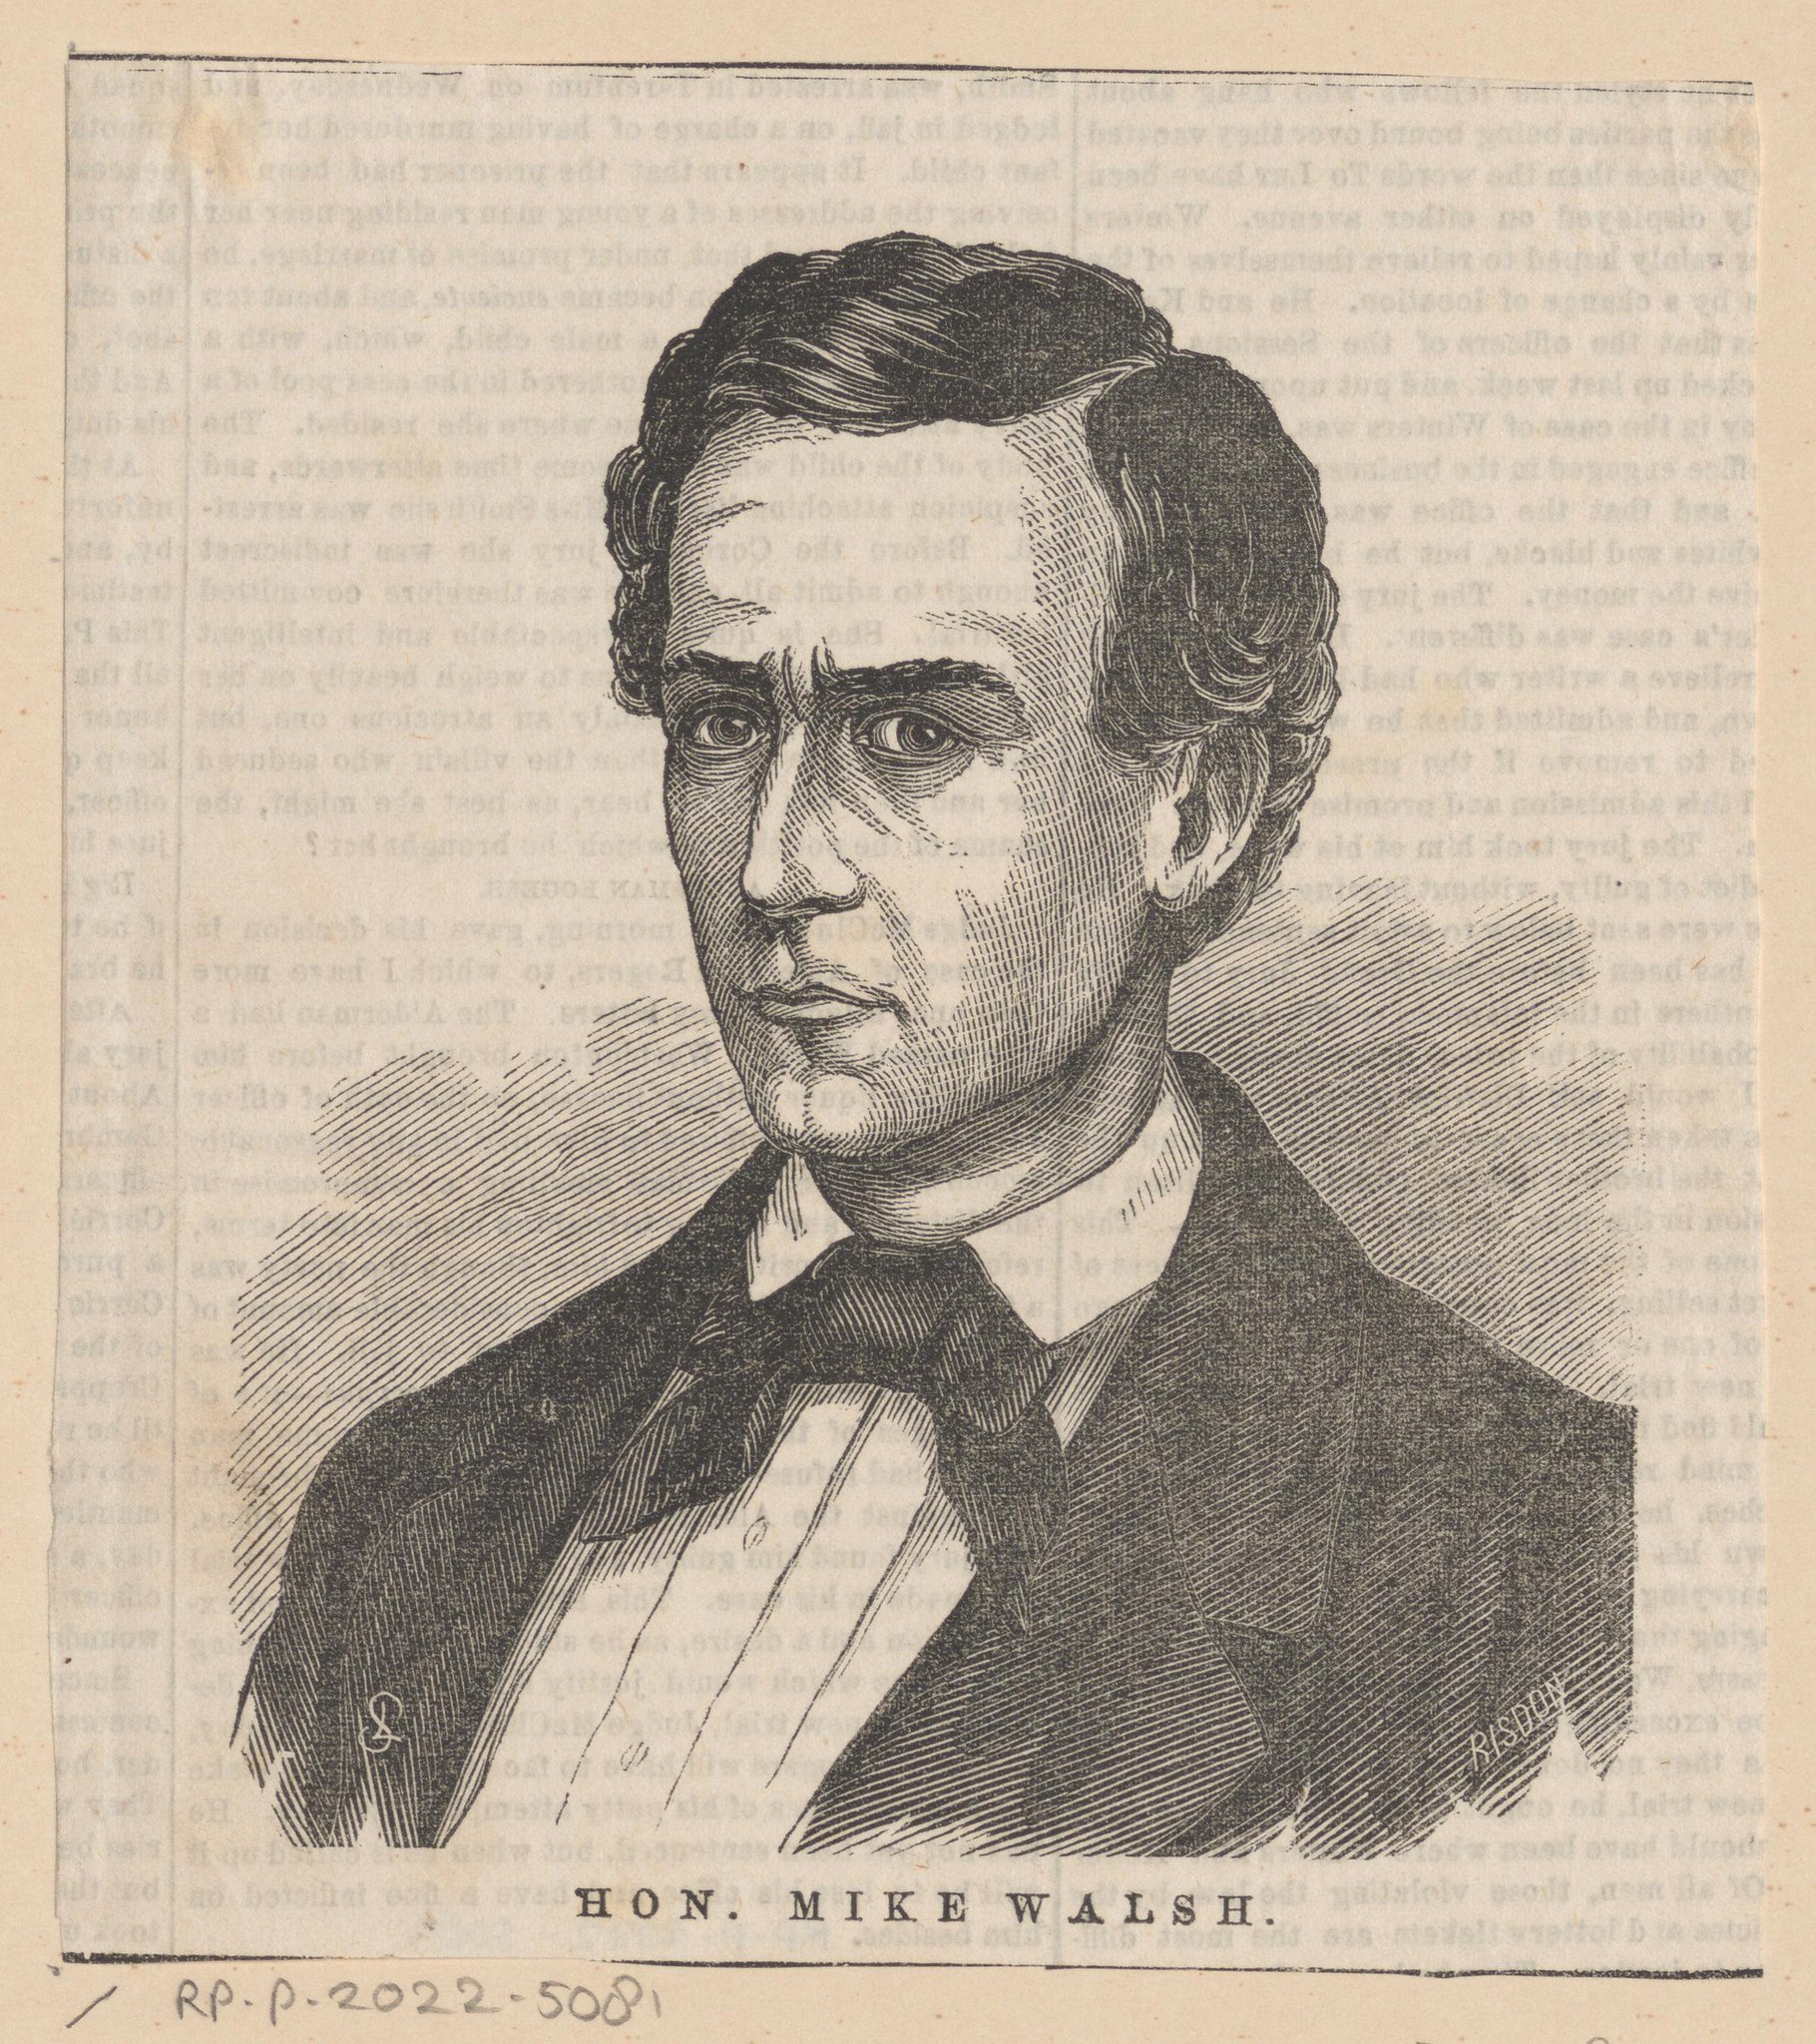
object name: print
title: Hon. Mike Walsh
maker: Anonymous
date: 1843-1899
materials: paper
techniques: letterpress printing, engraving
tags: new york (city), politician, historical persons, politician, e.g. party leader